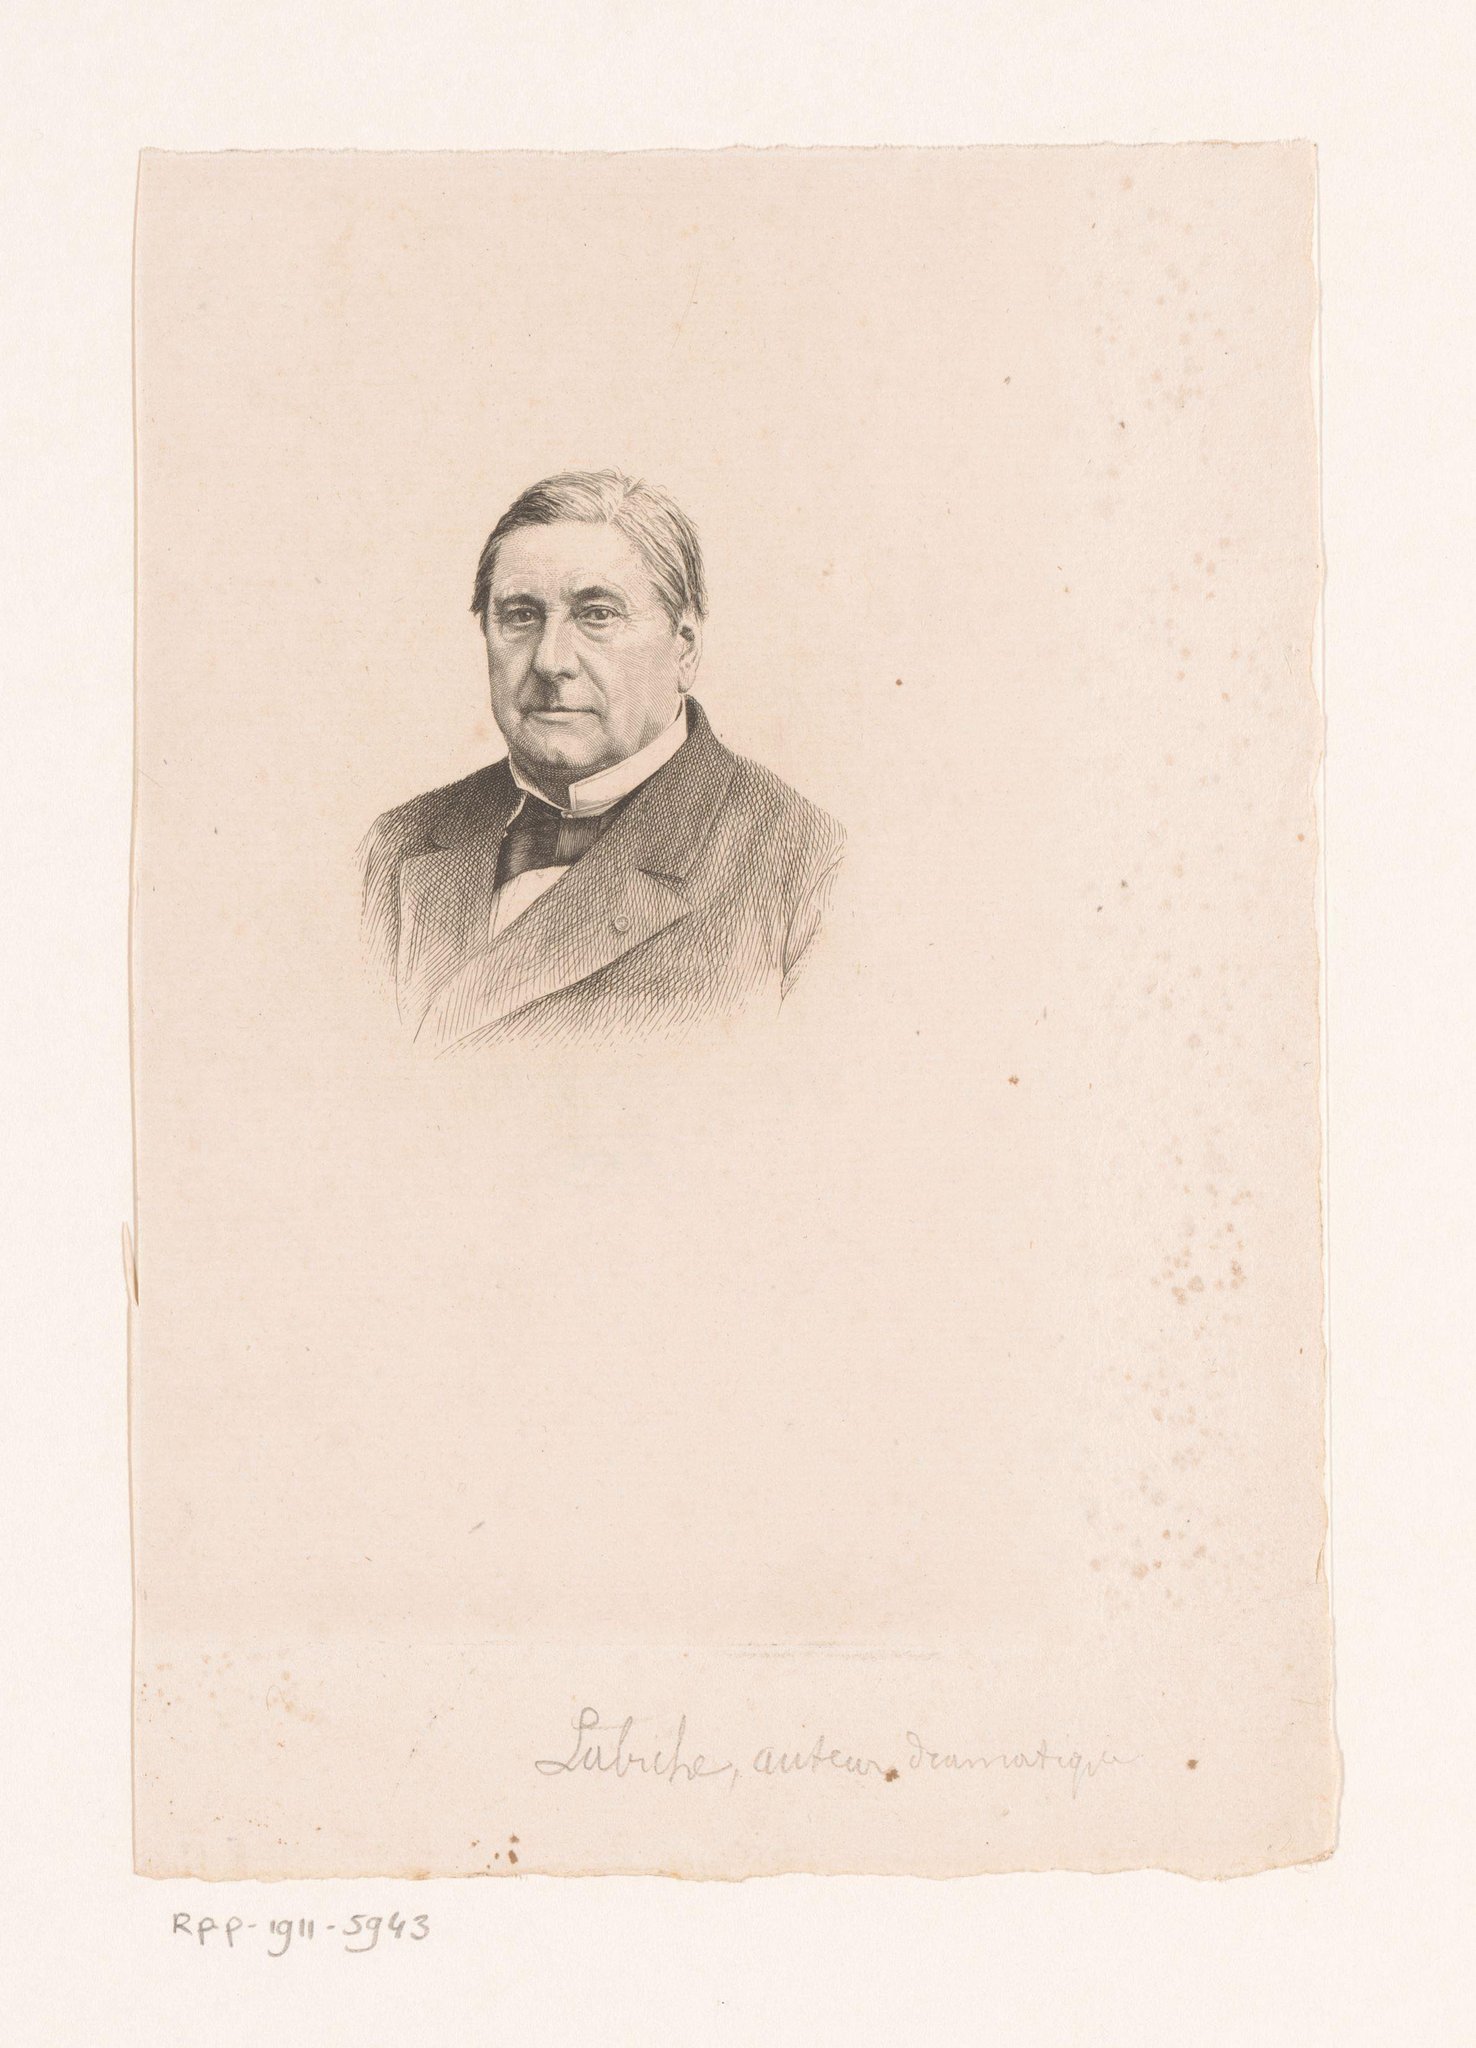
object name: print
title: Portret van Eugène Labiche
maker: louis le nain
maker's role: print maker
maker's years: 1851-1939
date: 1861-1911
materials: paper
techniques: etching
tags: adult man, historical persons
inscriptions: collector's mark: Lugt 2228